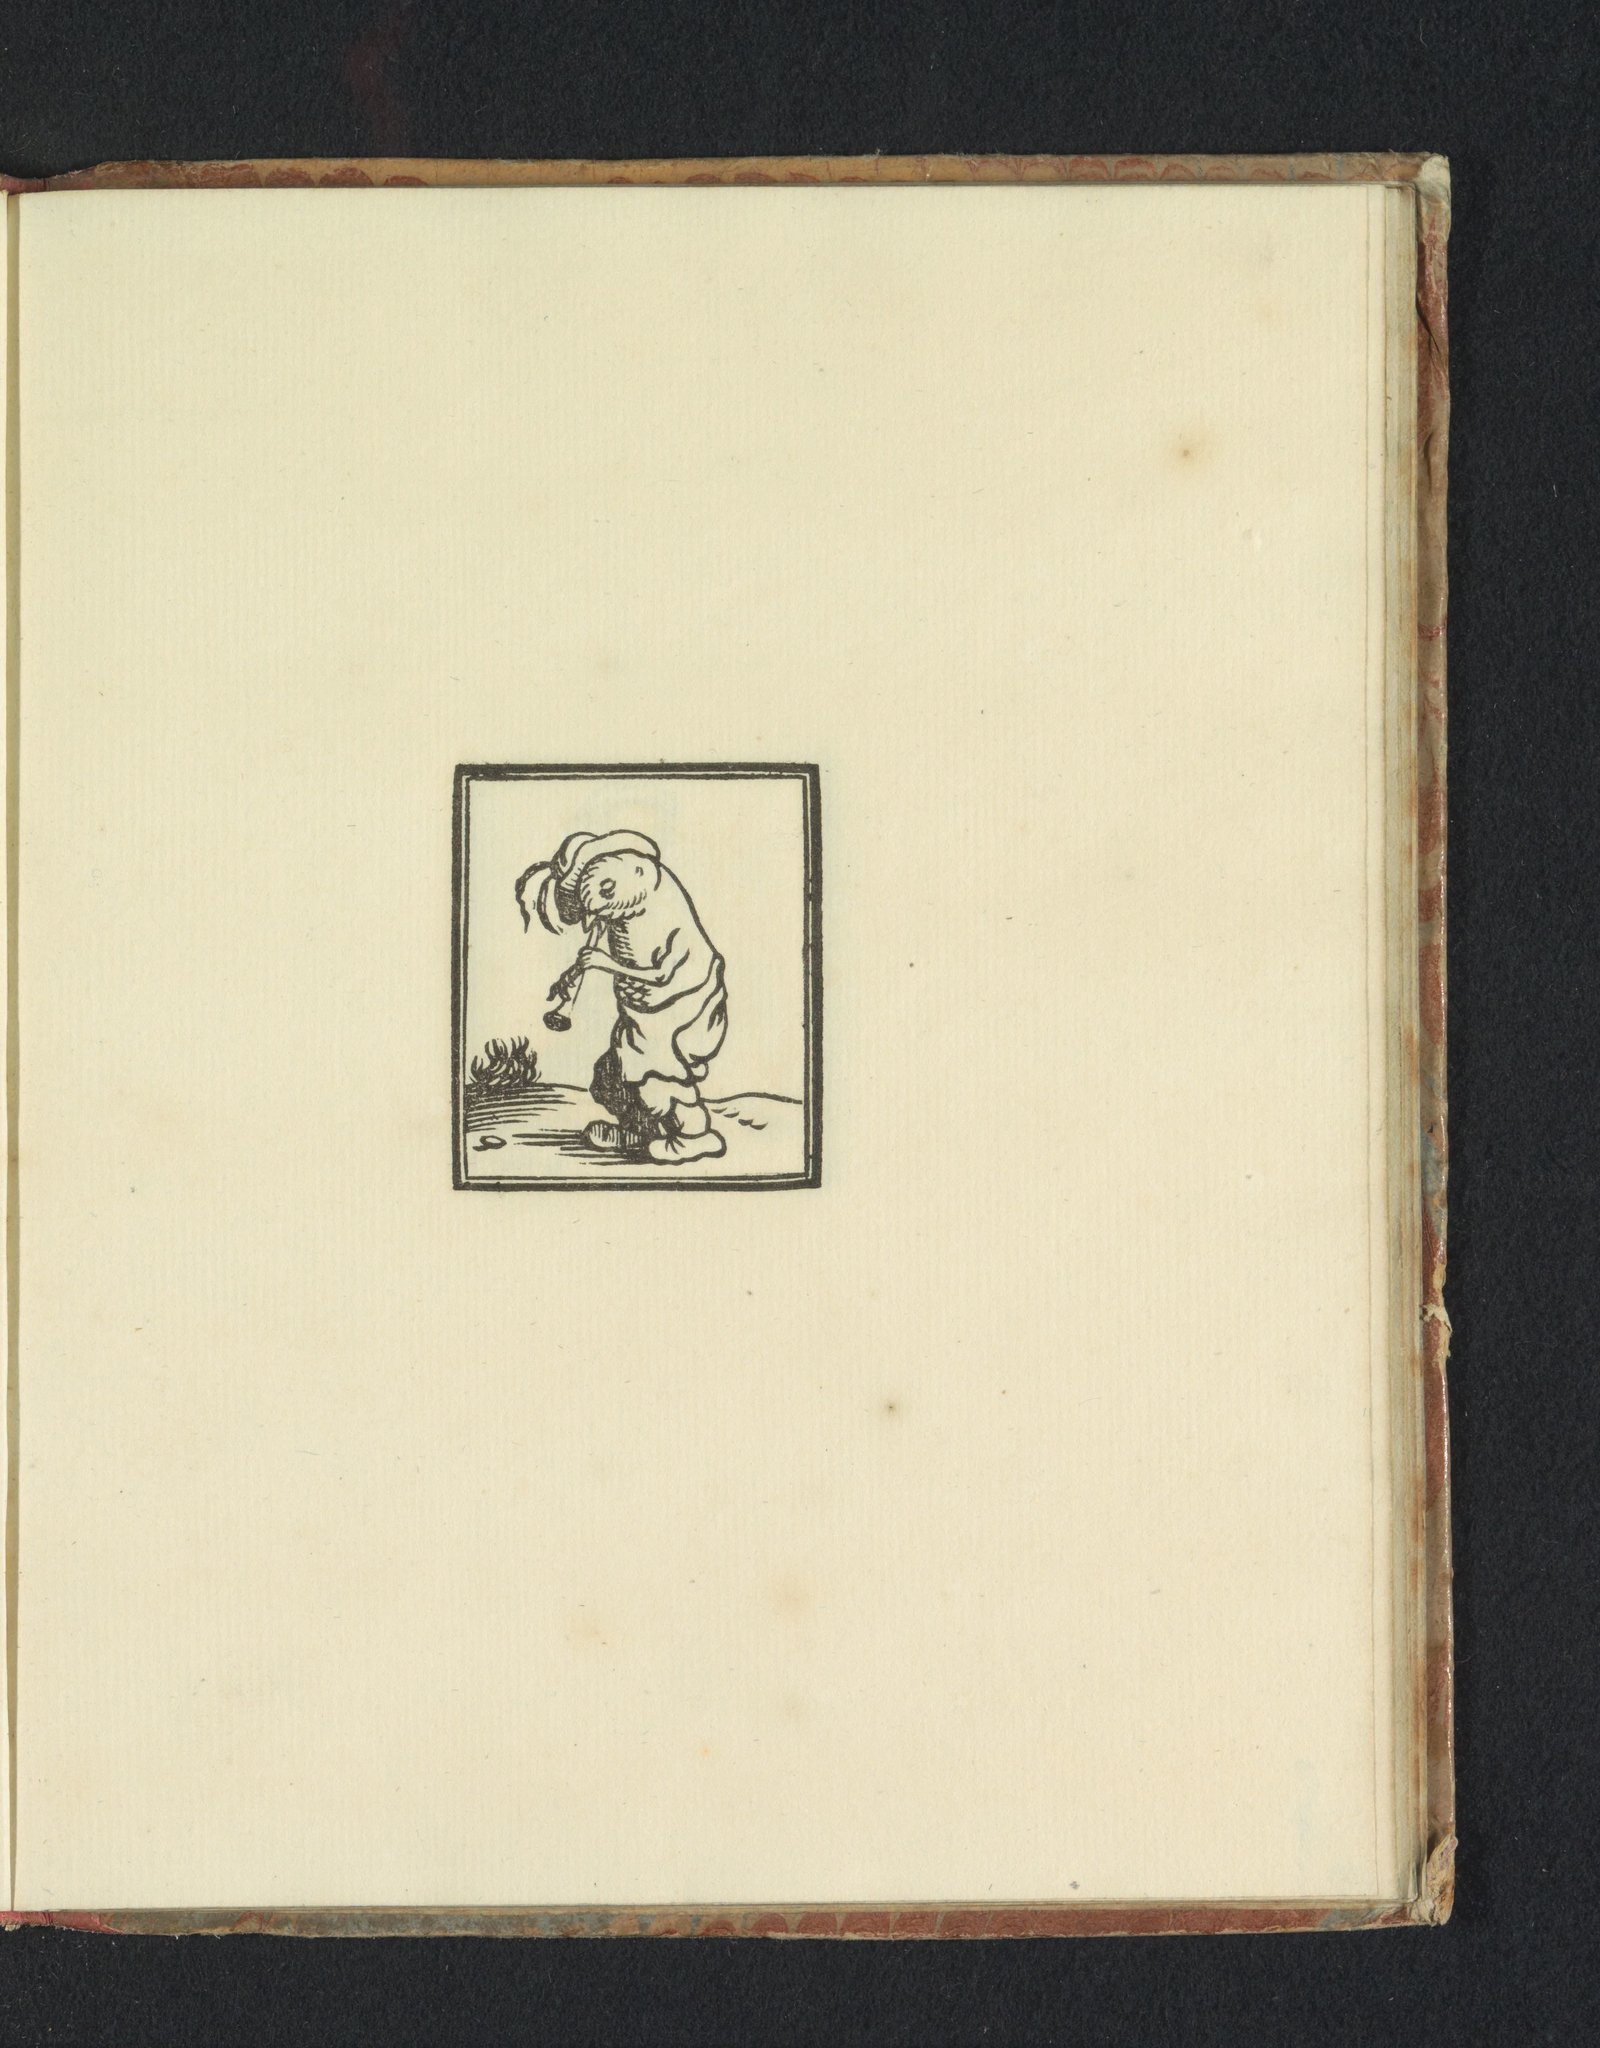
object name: popular print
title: Speel-vogel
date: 1731-1732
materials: paper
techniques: woodcut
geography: haarlem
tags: caricatures (human types)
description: Koddige figuur, in het onderschrift in de overzichtsprent draagt deze figuur de naam: Speel-vogel. Onderdeel van het boekje: XXXVI. aartige figuuren, geinventeert door Izaak van Ostade tot Haarlem [1731-1732].